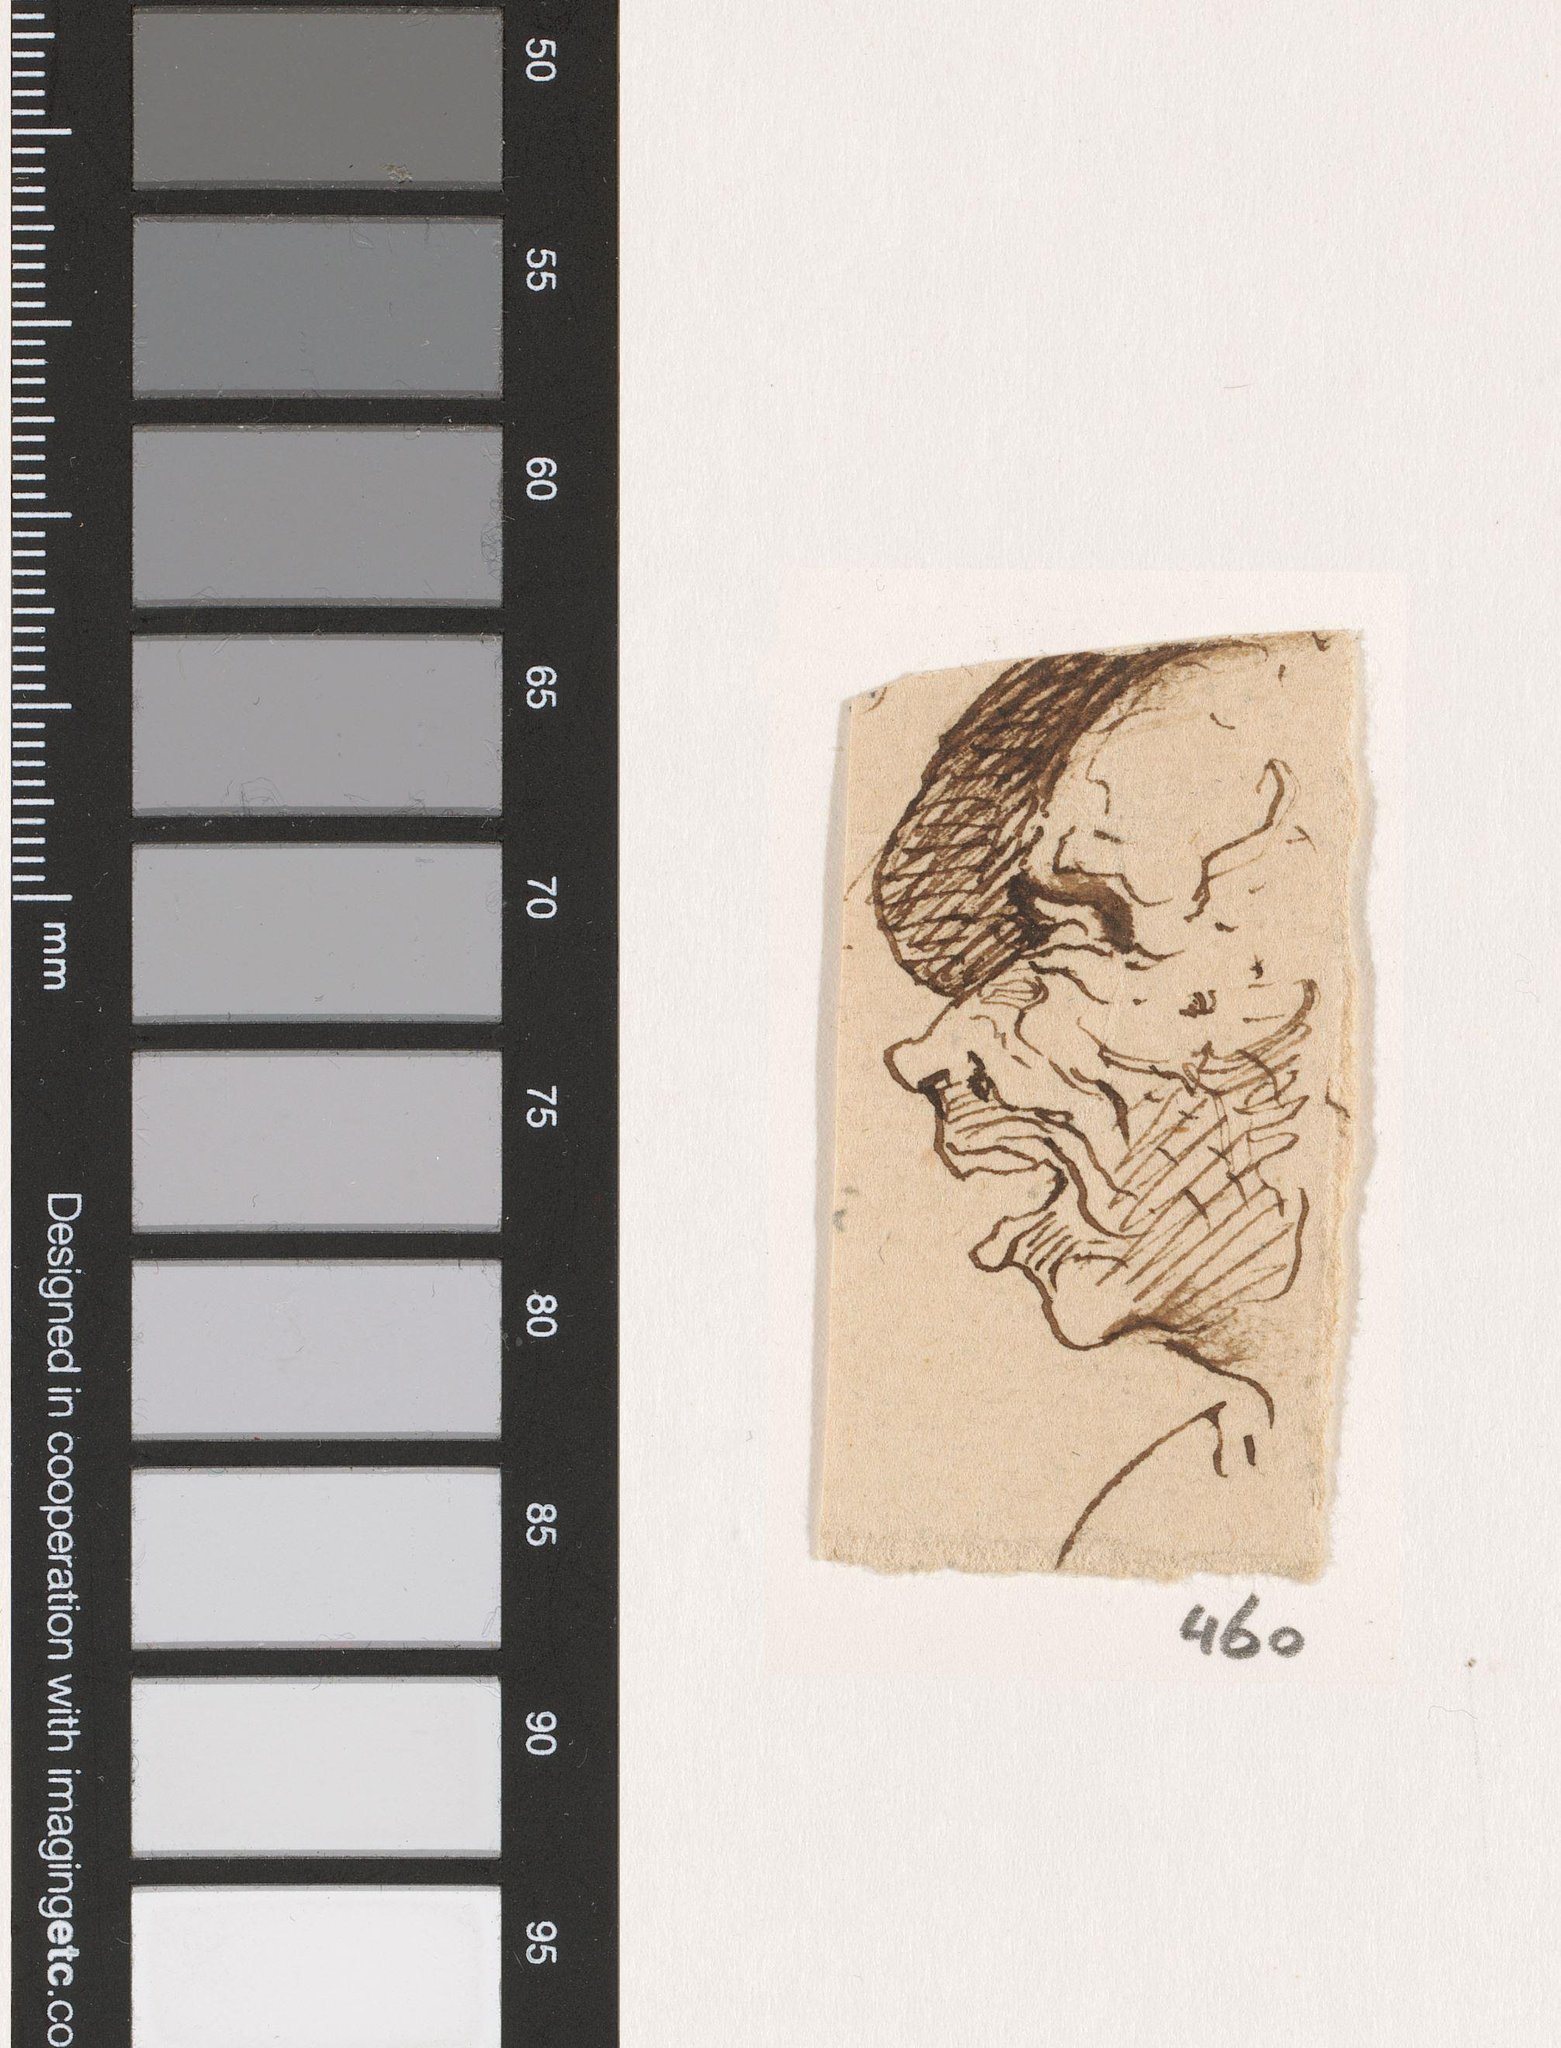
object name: drawing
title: Kop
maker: johannes tavenraat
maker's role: draughtsman, painter, print maker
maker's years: 1809-1881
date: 1840-1880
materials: ink, paper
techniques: pen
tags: caricatures (human types)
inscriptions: collector's mark: Lugt 2228